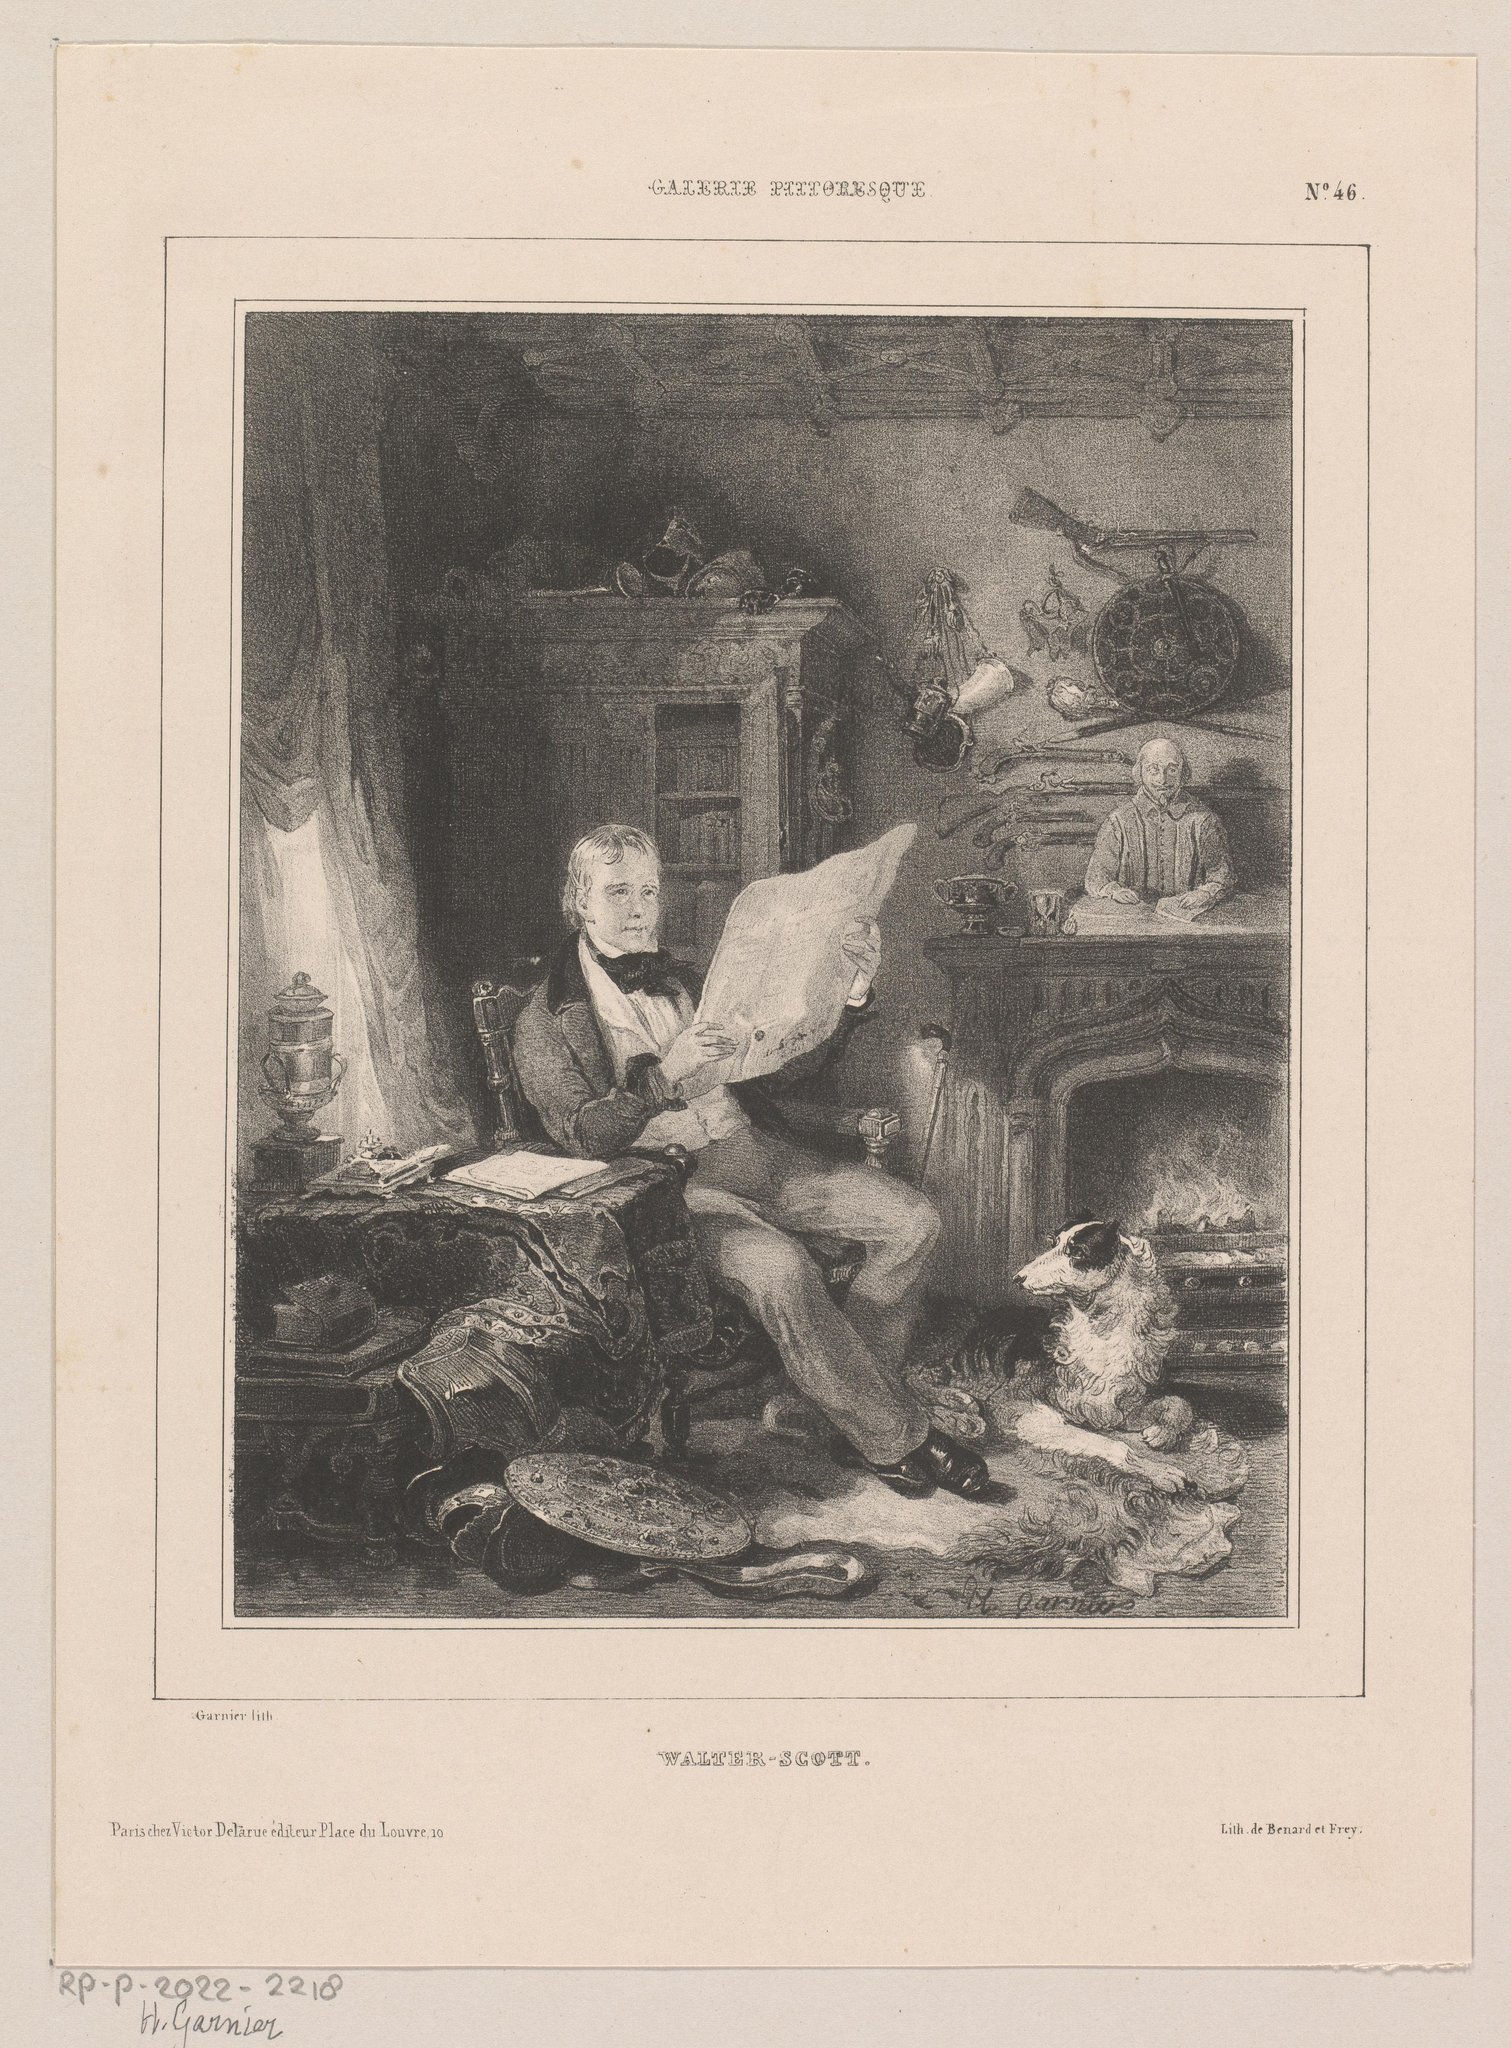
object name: print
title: Galerie pittoresque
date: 1827-1839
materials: paper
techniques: lithograph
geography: paris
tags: walter scott, historical persons, portrait of a writer, writer, poet, author